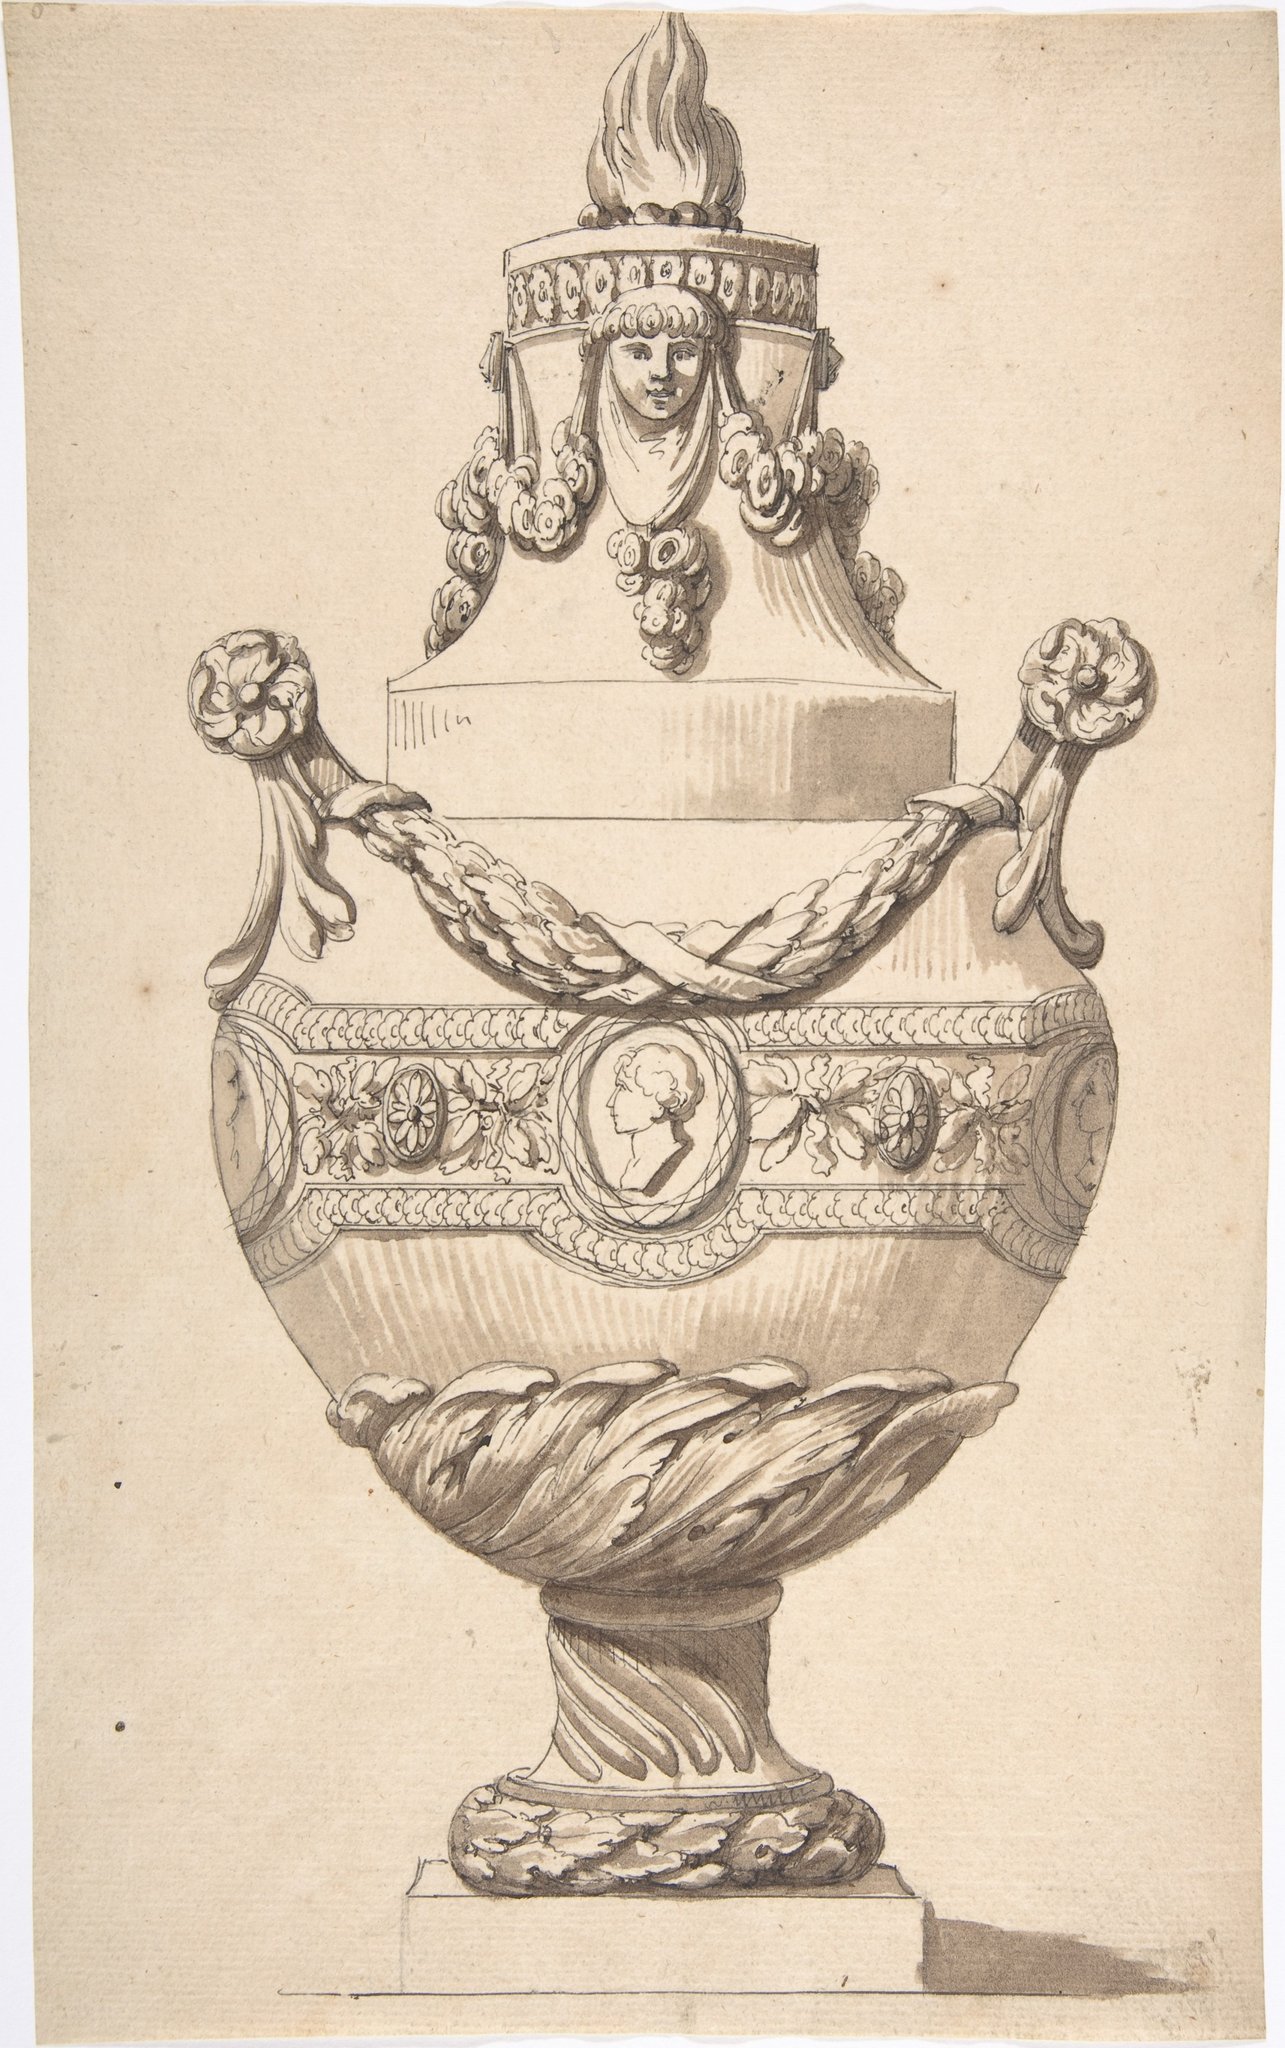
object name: drawing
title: Urn with Acanthus Base and Flambeaux Top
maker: anonymous, french, 18th century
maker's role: artist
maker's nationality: french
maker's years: 1700-1800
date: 1701-1800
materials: graphite, ink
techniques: brush, pen, wash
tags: heads,profiles,flowers,leaves,urns